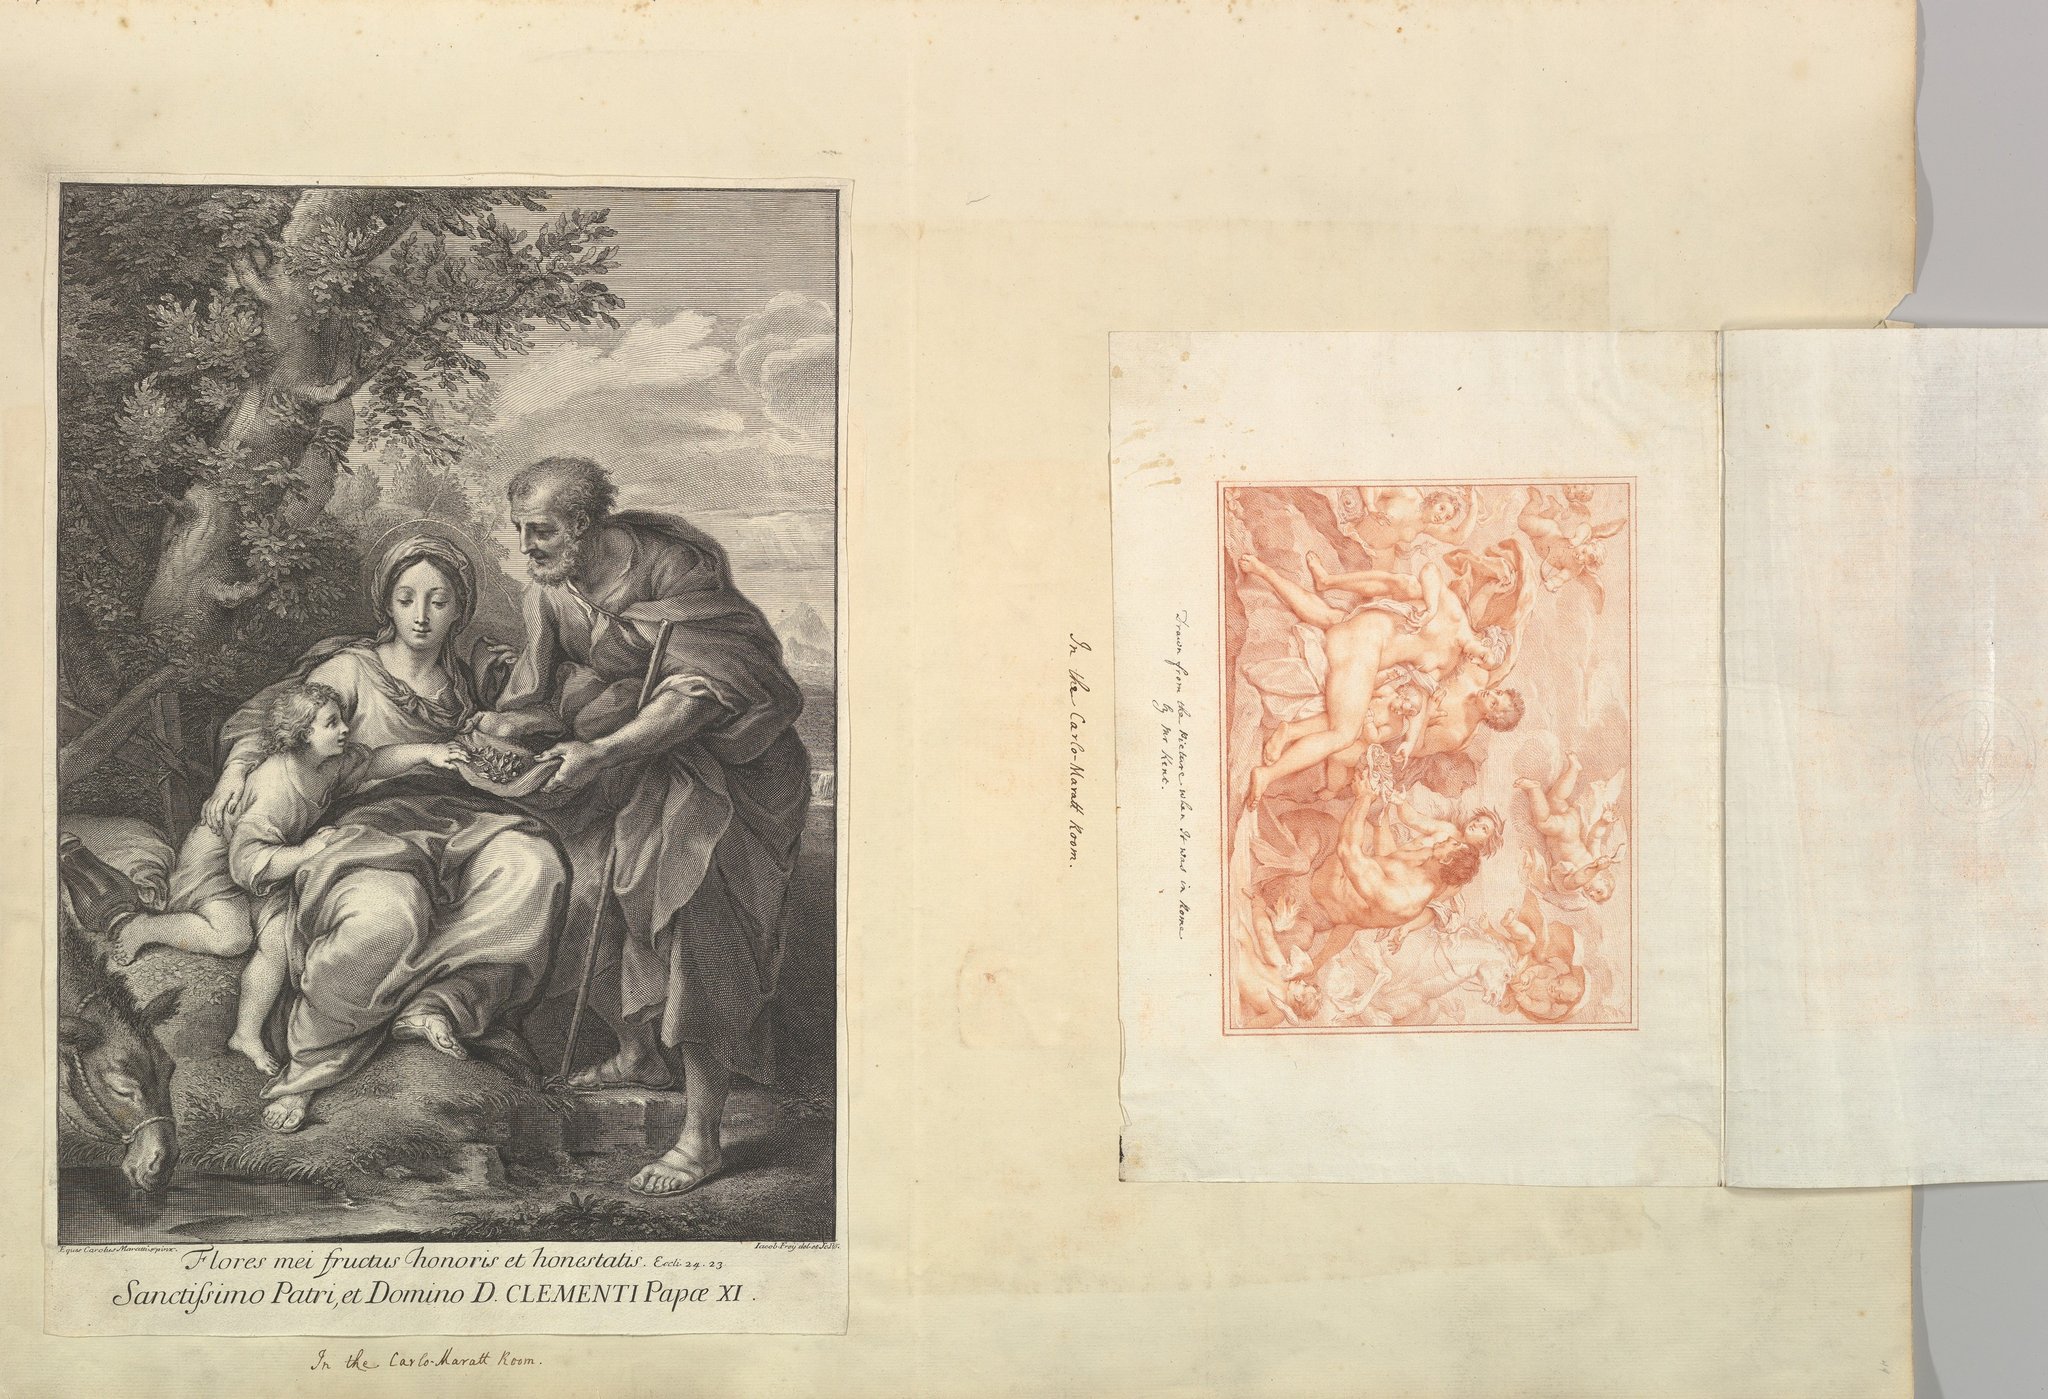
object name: print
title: Leaf from Aedes Walpolianae mounted with a print and a drawing: (a): The Virgin and Joseph with the Young Jesus; (b): Acis and Galatea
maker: johann jakob frey the elder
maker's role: artist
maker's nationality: swiss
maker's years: 1681-1752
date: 1710-1740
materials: chalk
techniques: engraving, etching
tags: galatea,holy family